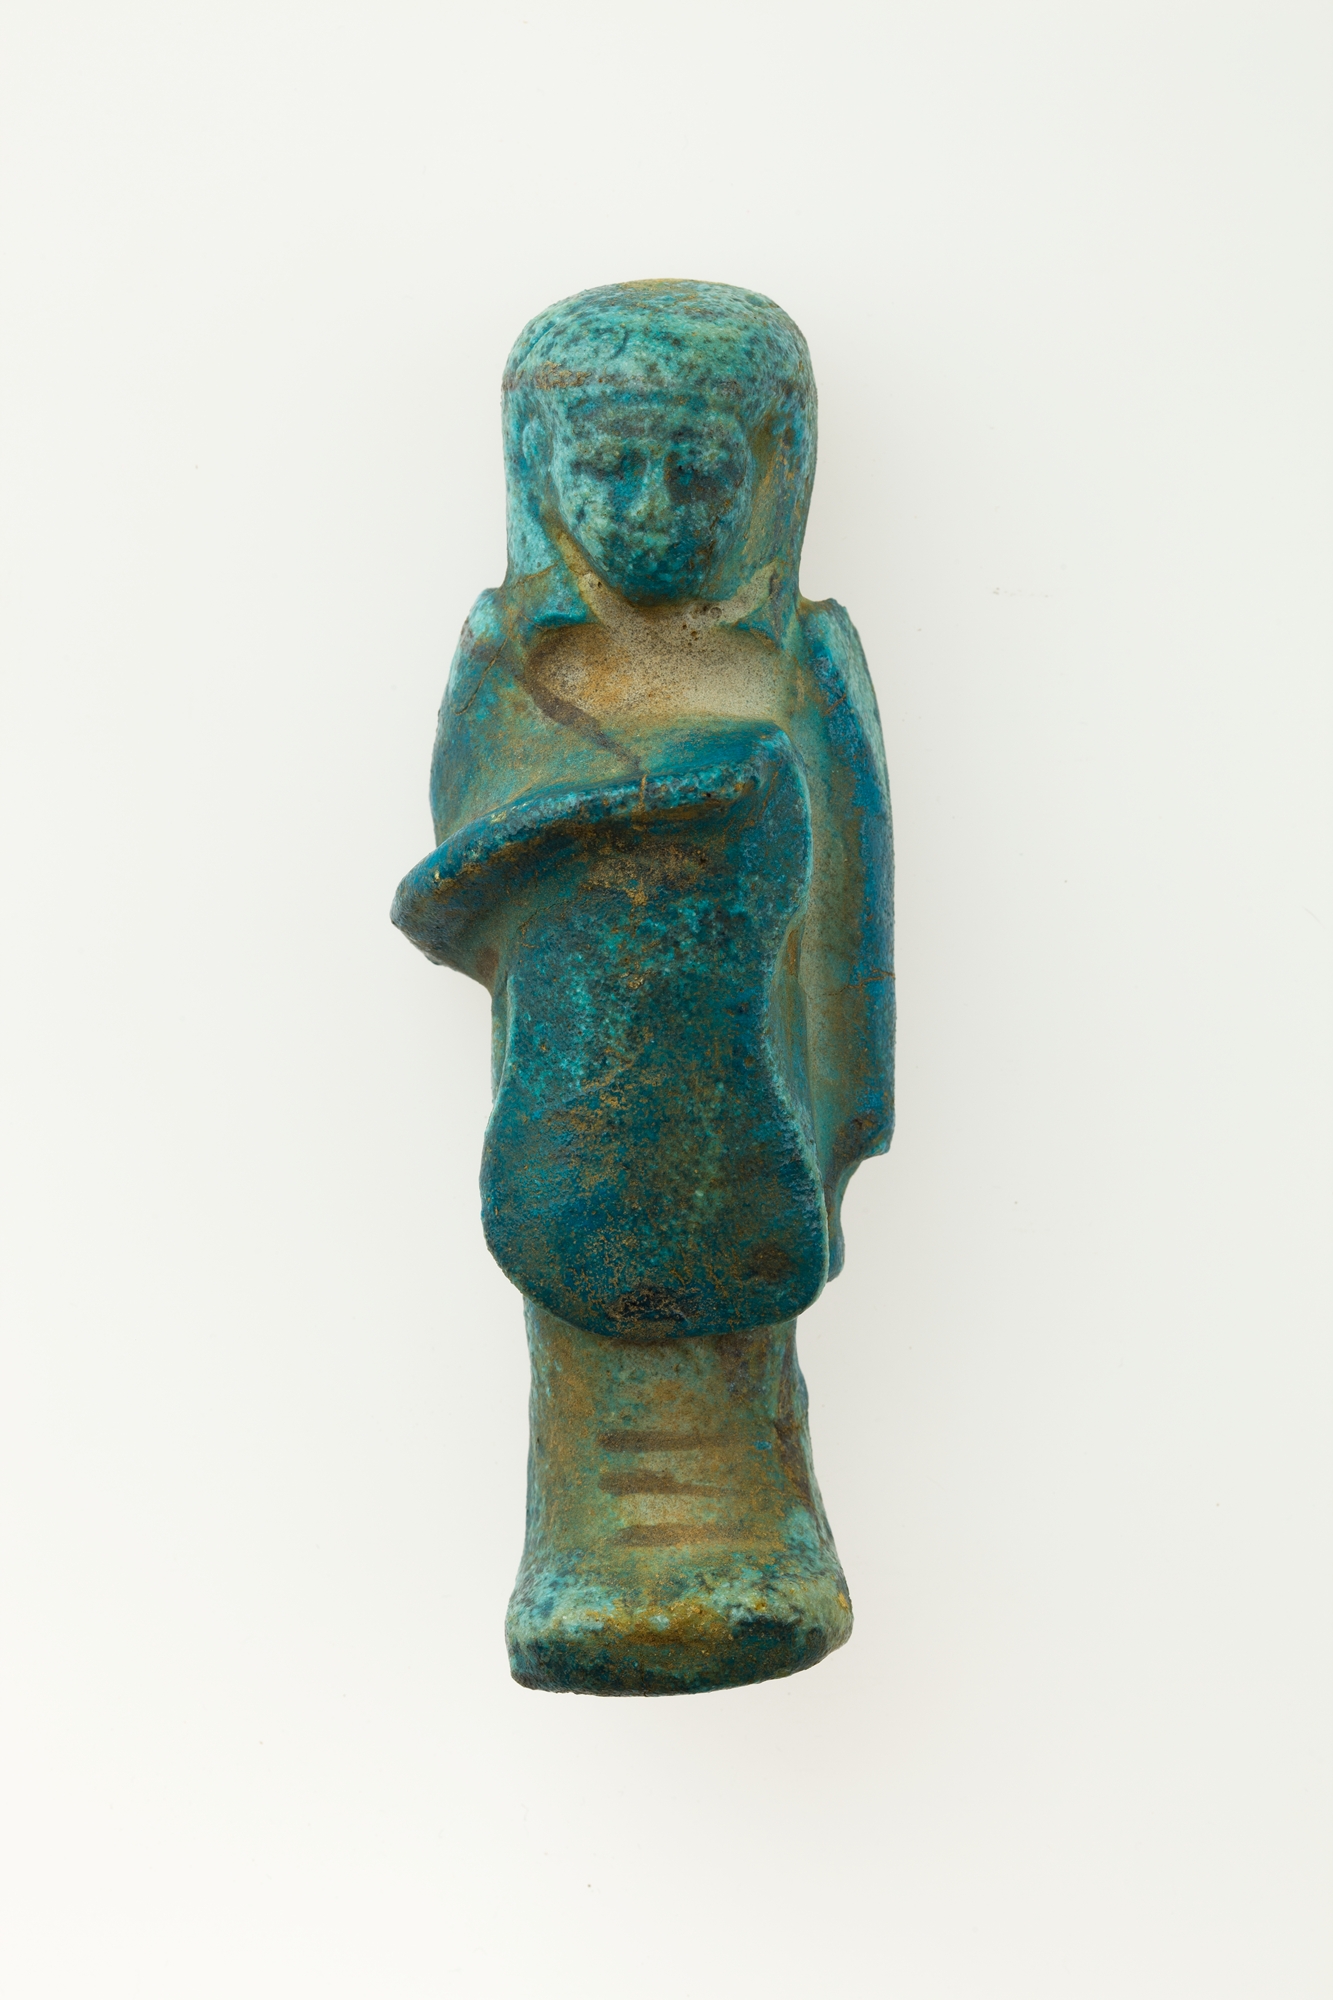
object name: shabti, henettawy c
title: Overseer Shabti of Henettawy (C), Daughter of Isetemkheb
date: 990-970 BCE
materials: faience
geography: egypt